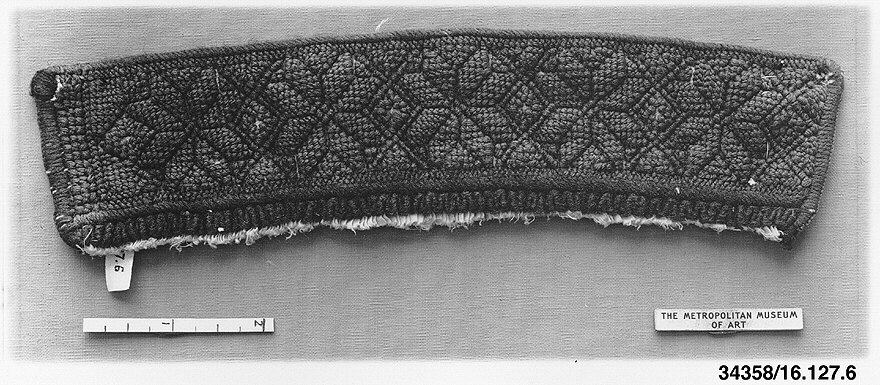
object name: strip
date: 1801-1900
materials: wool